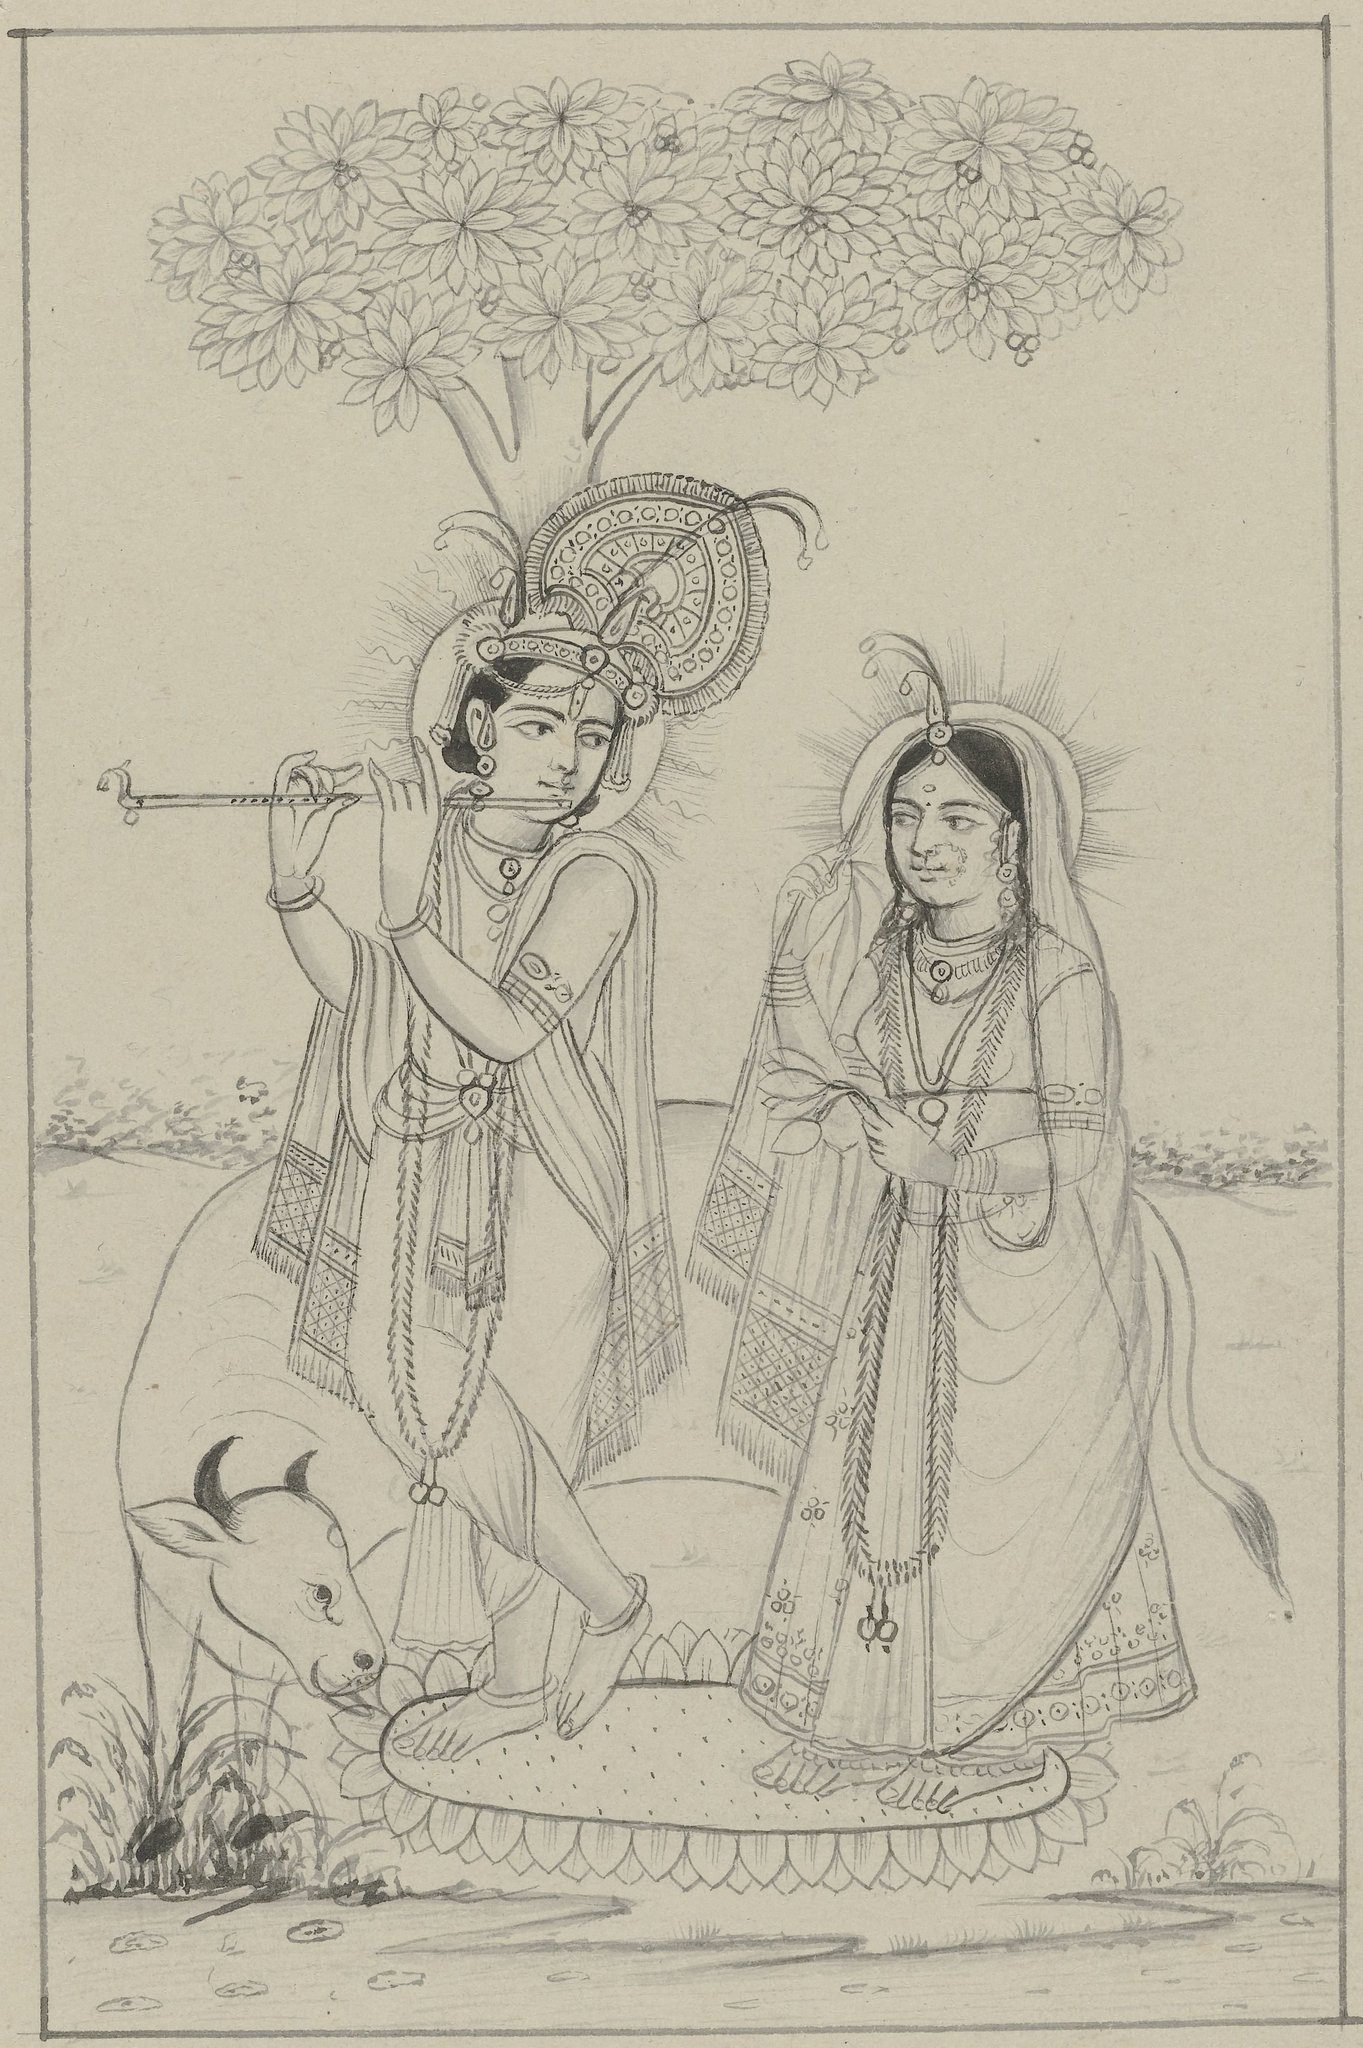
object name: drawing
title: Krishna, die op een fluit speelt, en Radha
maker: Anonymous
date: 1800-1899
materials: paper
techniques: brush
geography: jaipur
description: Krishna en Radha staan samen op een lotuskleed bij een boom, Krishna speelt op zijn fluit en kijkt achterom naar Radha die van achter haar sluier verlegen naar hem kijkt; een koe likt Krishna's voeten